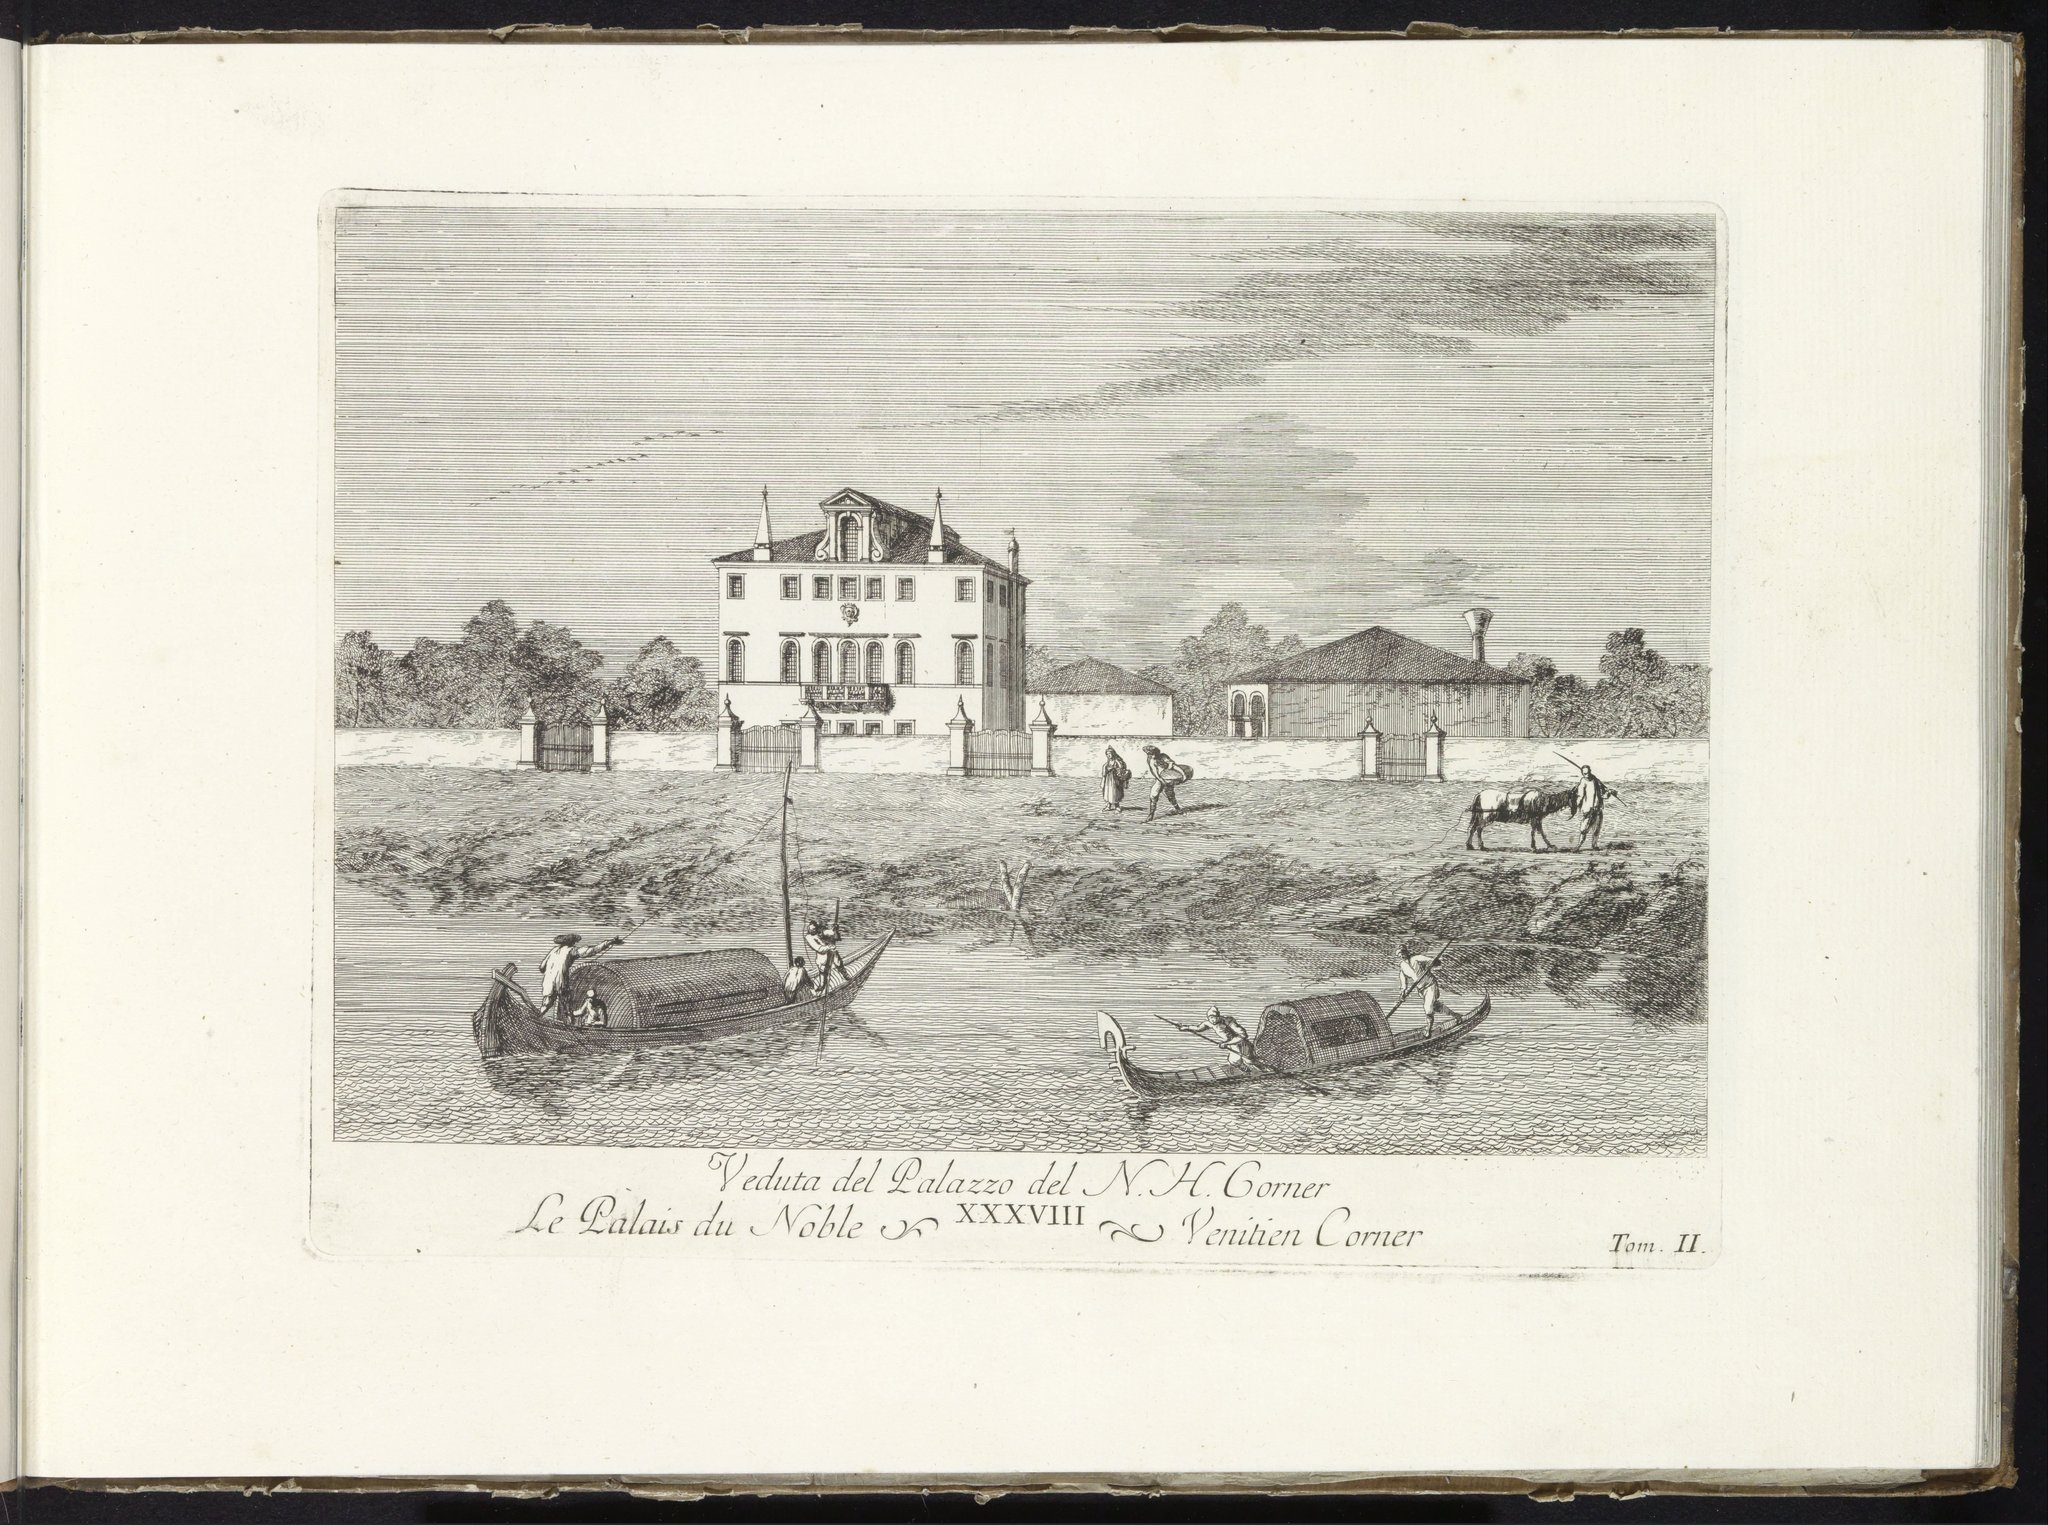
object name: print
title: Veduta del Palazzo del N. H. Corner (...)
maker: giovanni francesco costa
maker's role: draughtsman, painter, print maker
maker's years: -1773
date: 1750-1760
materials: paper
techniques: etching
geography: italy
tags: river, tow-boat, towing-barge, hôtel, i.e. small palace in city, gondola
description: Gezicht op Palazzo del N. H. Corner aan de rivier de Brenta. Op het water varen een gondel en een trekschuit. Genummerd midden onder: XXXVIII en rechtsonder: Tom: II. Deze prent maakt deel uit van een album.